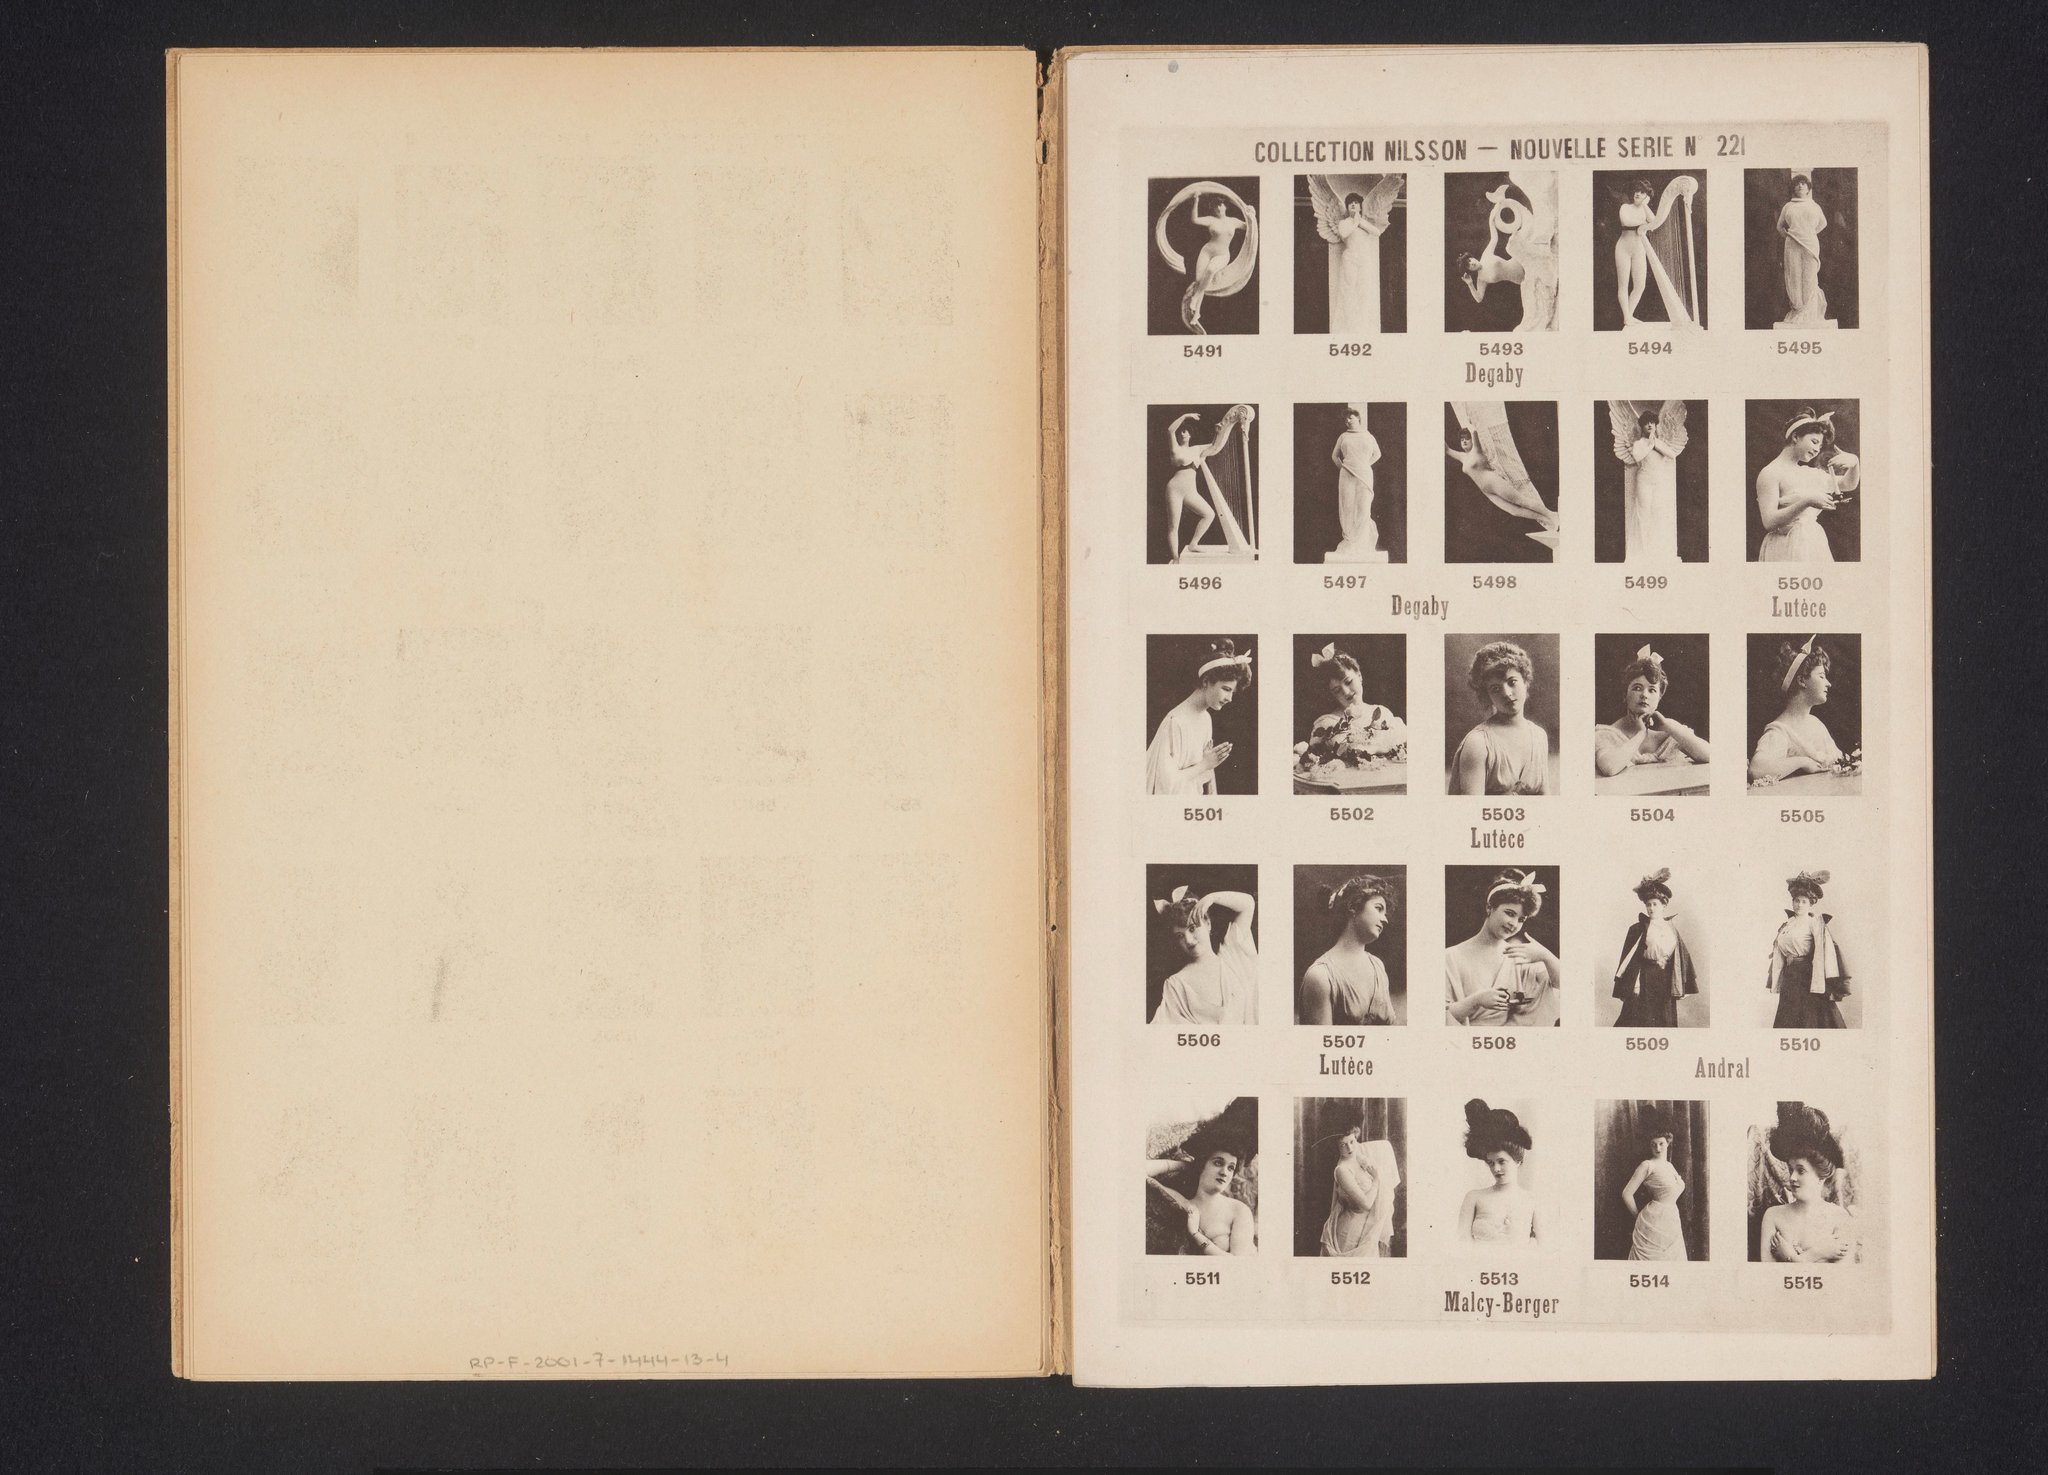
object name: page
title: Collection Nilsson - Nouvelle Série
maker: Anonymous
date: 1894-1899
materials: paper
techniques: photograph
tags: historical persons - bb - woman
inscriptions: number: ‘No 221’